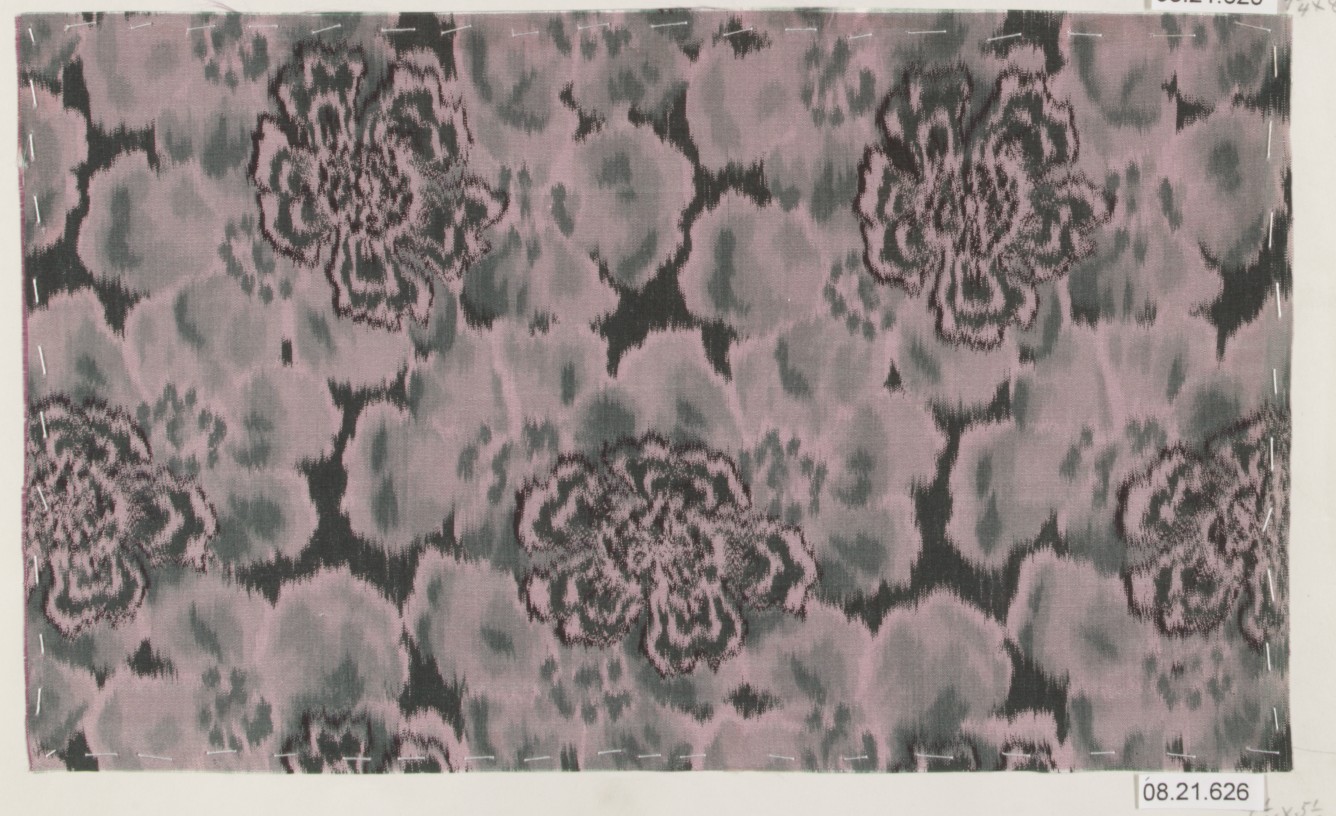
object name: textile sample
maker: Anonymous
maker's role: designer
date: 1900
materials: silk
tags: flowers